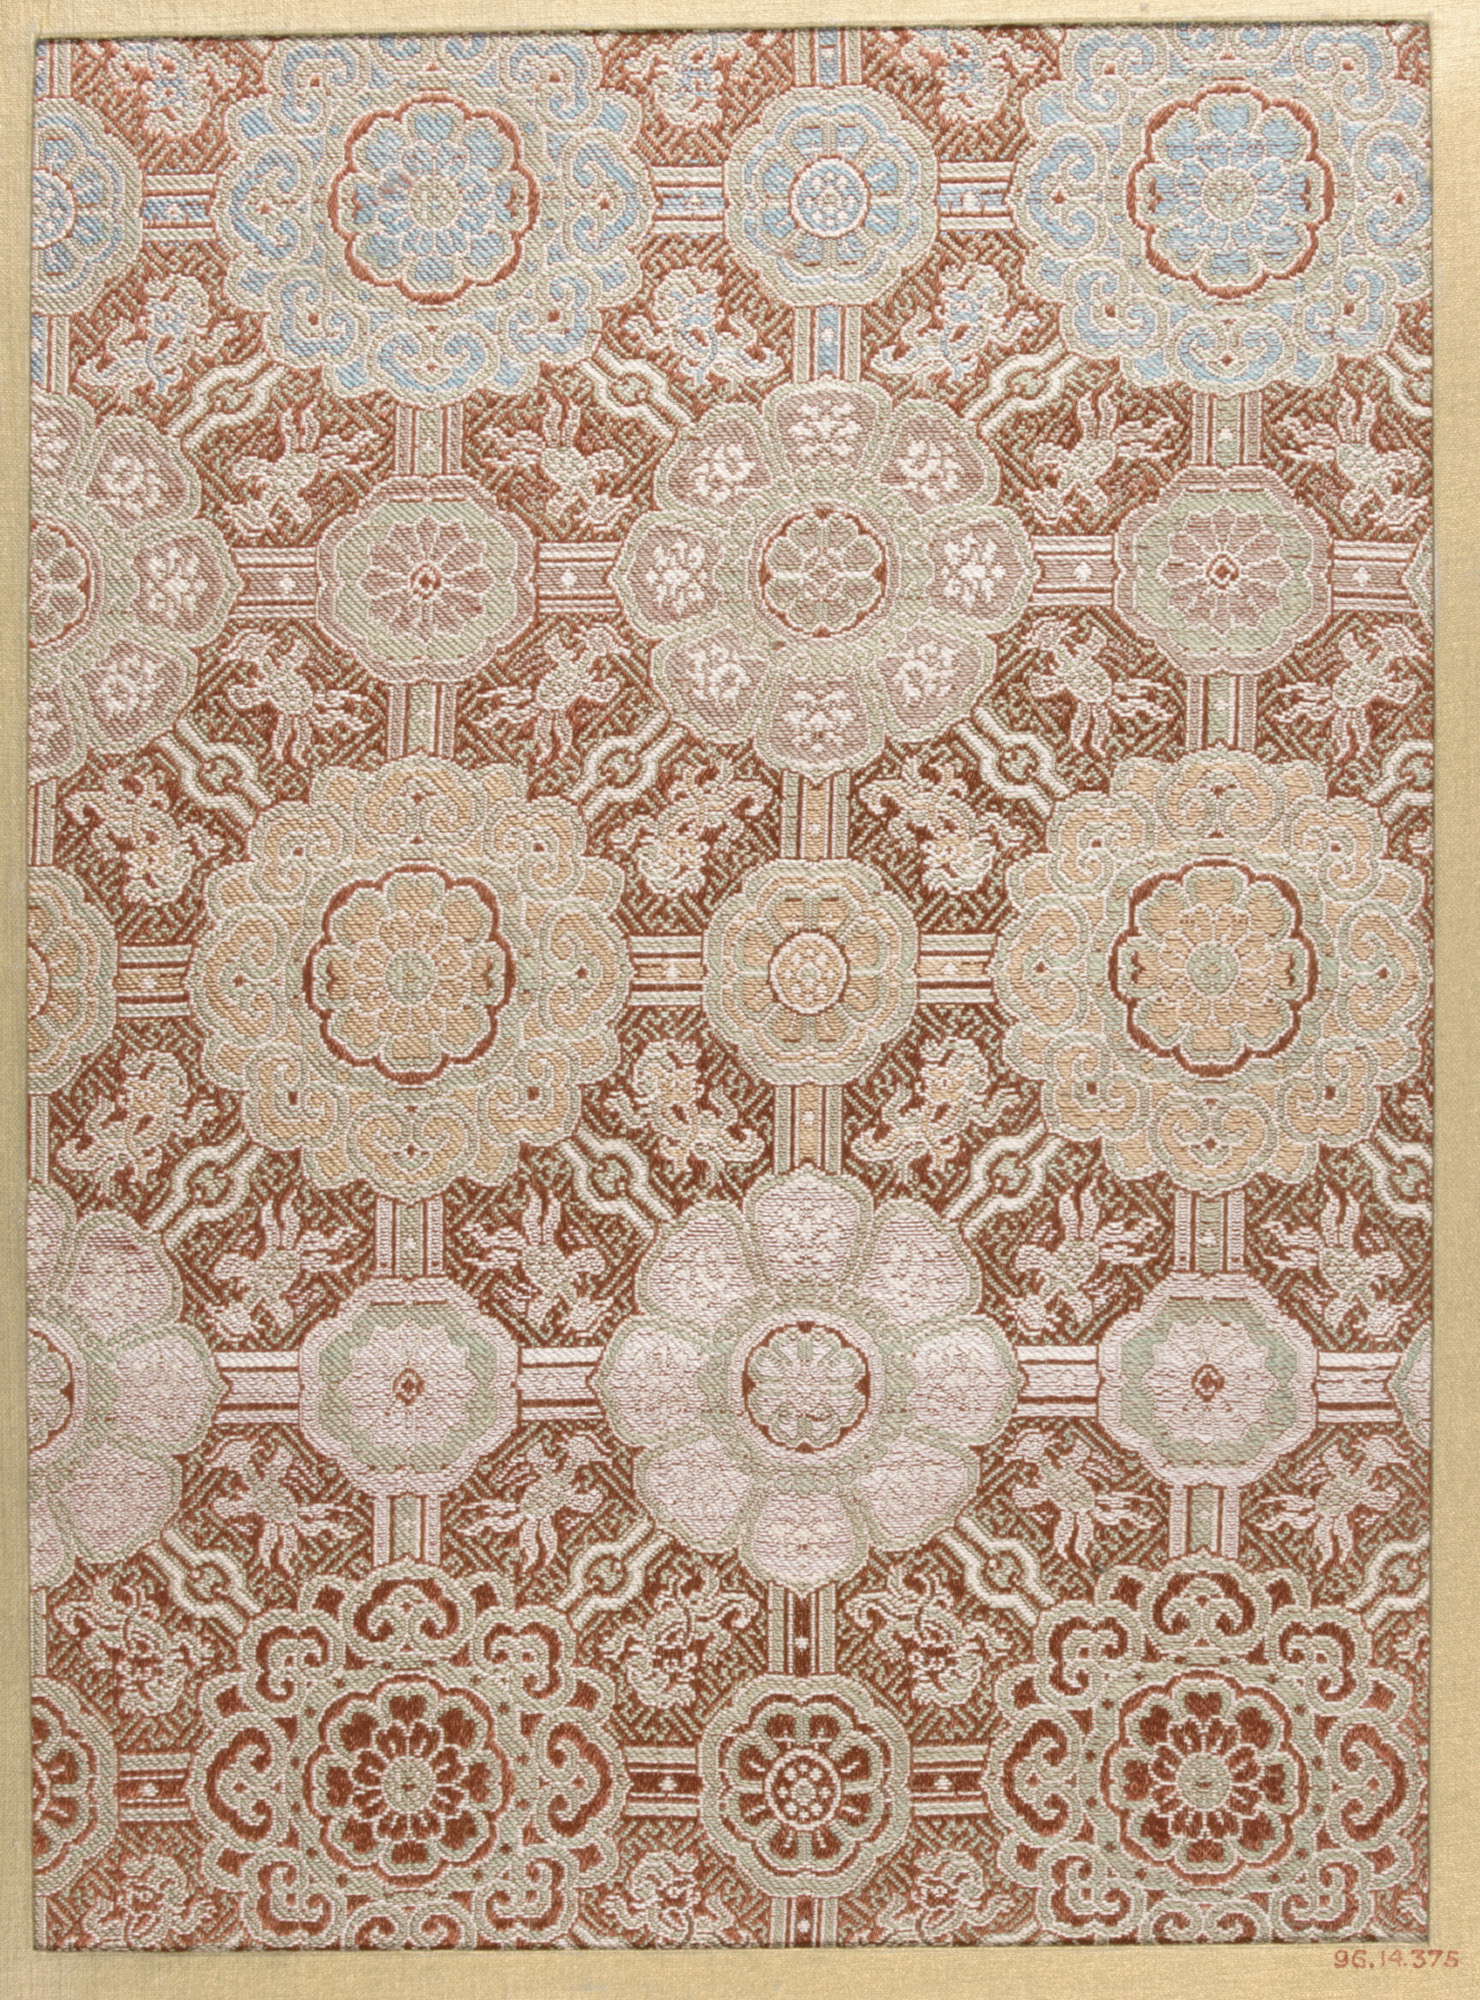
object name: piece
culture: japanese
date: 1701-1900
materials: silk